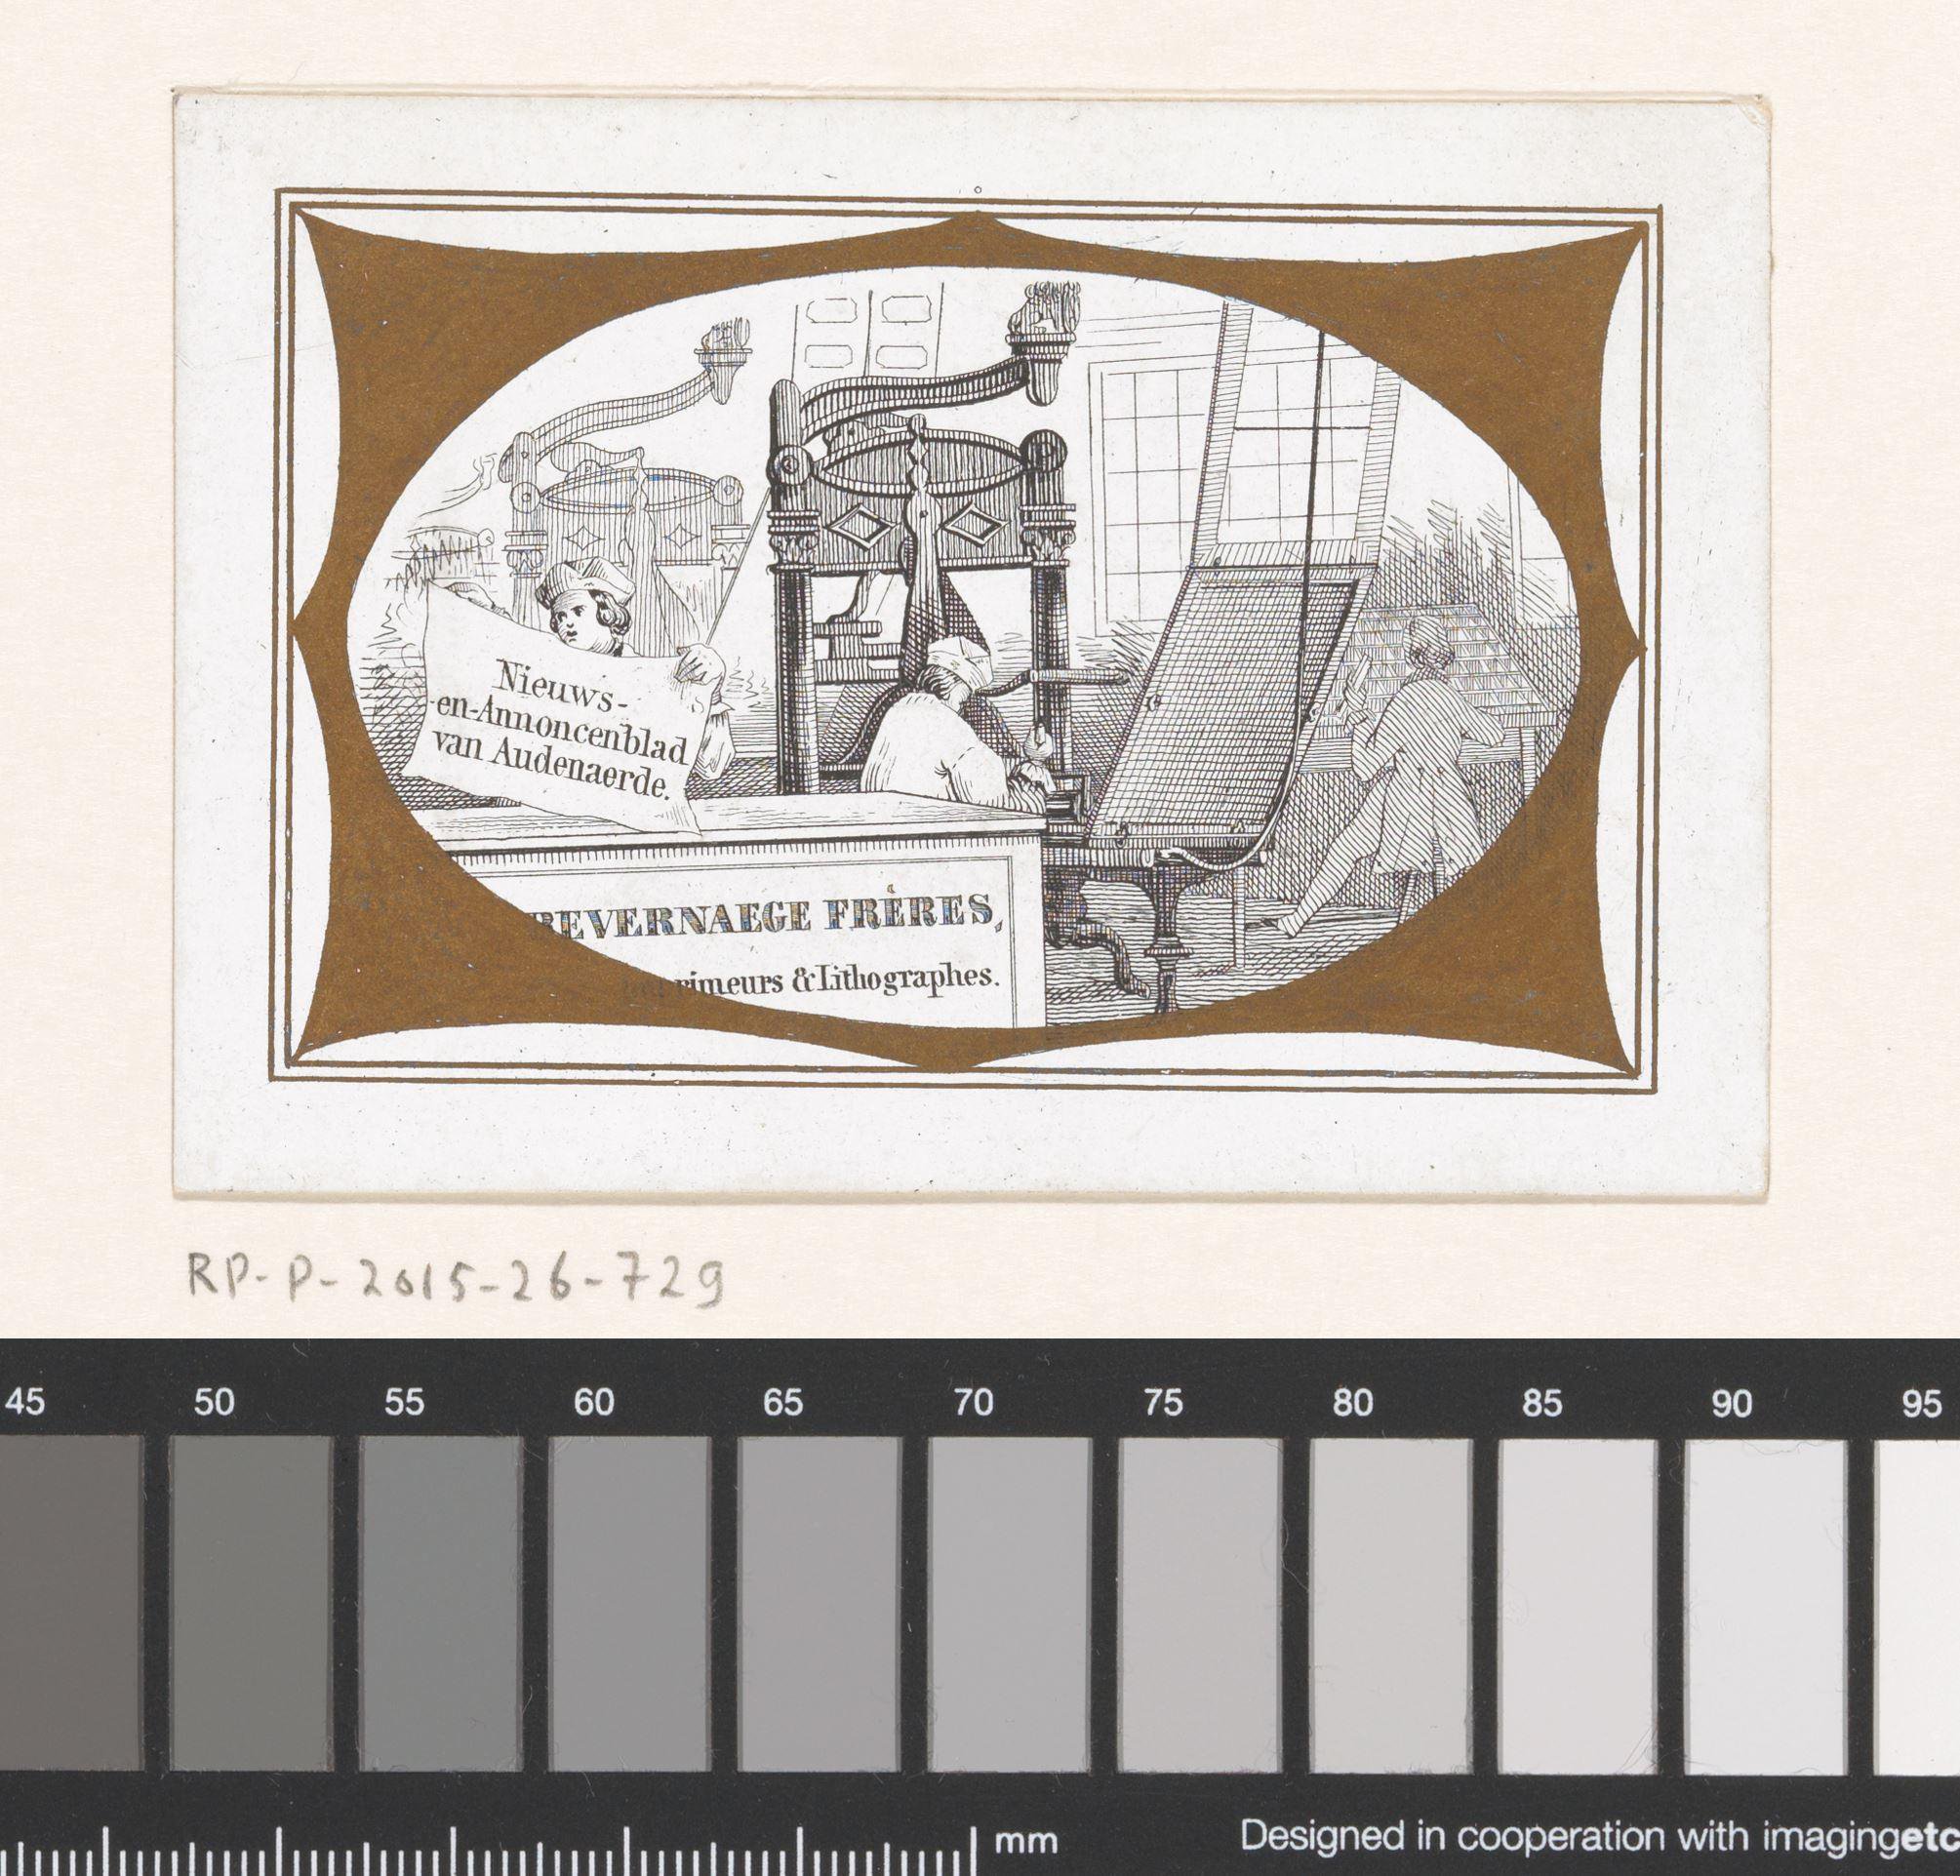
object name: porcelain card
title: Visitekaartje van het Nieuws- en Annoncenblad van Audenaerde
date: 1840-1875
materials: porcelainized cardboard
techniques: lithograph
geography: oudenaarde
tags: printing press, newspaper, news-sheet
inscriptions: collector's mark: Lugt 2228, collector's mark: Lugt 4780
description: Interieur van een drukkerij met in het midden een man achter een drukpers en in de achtergrond een letterzetter.